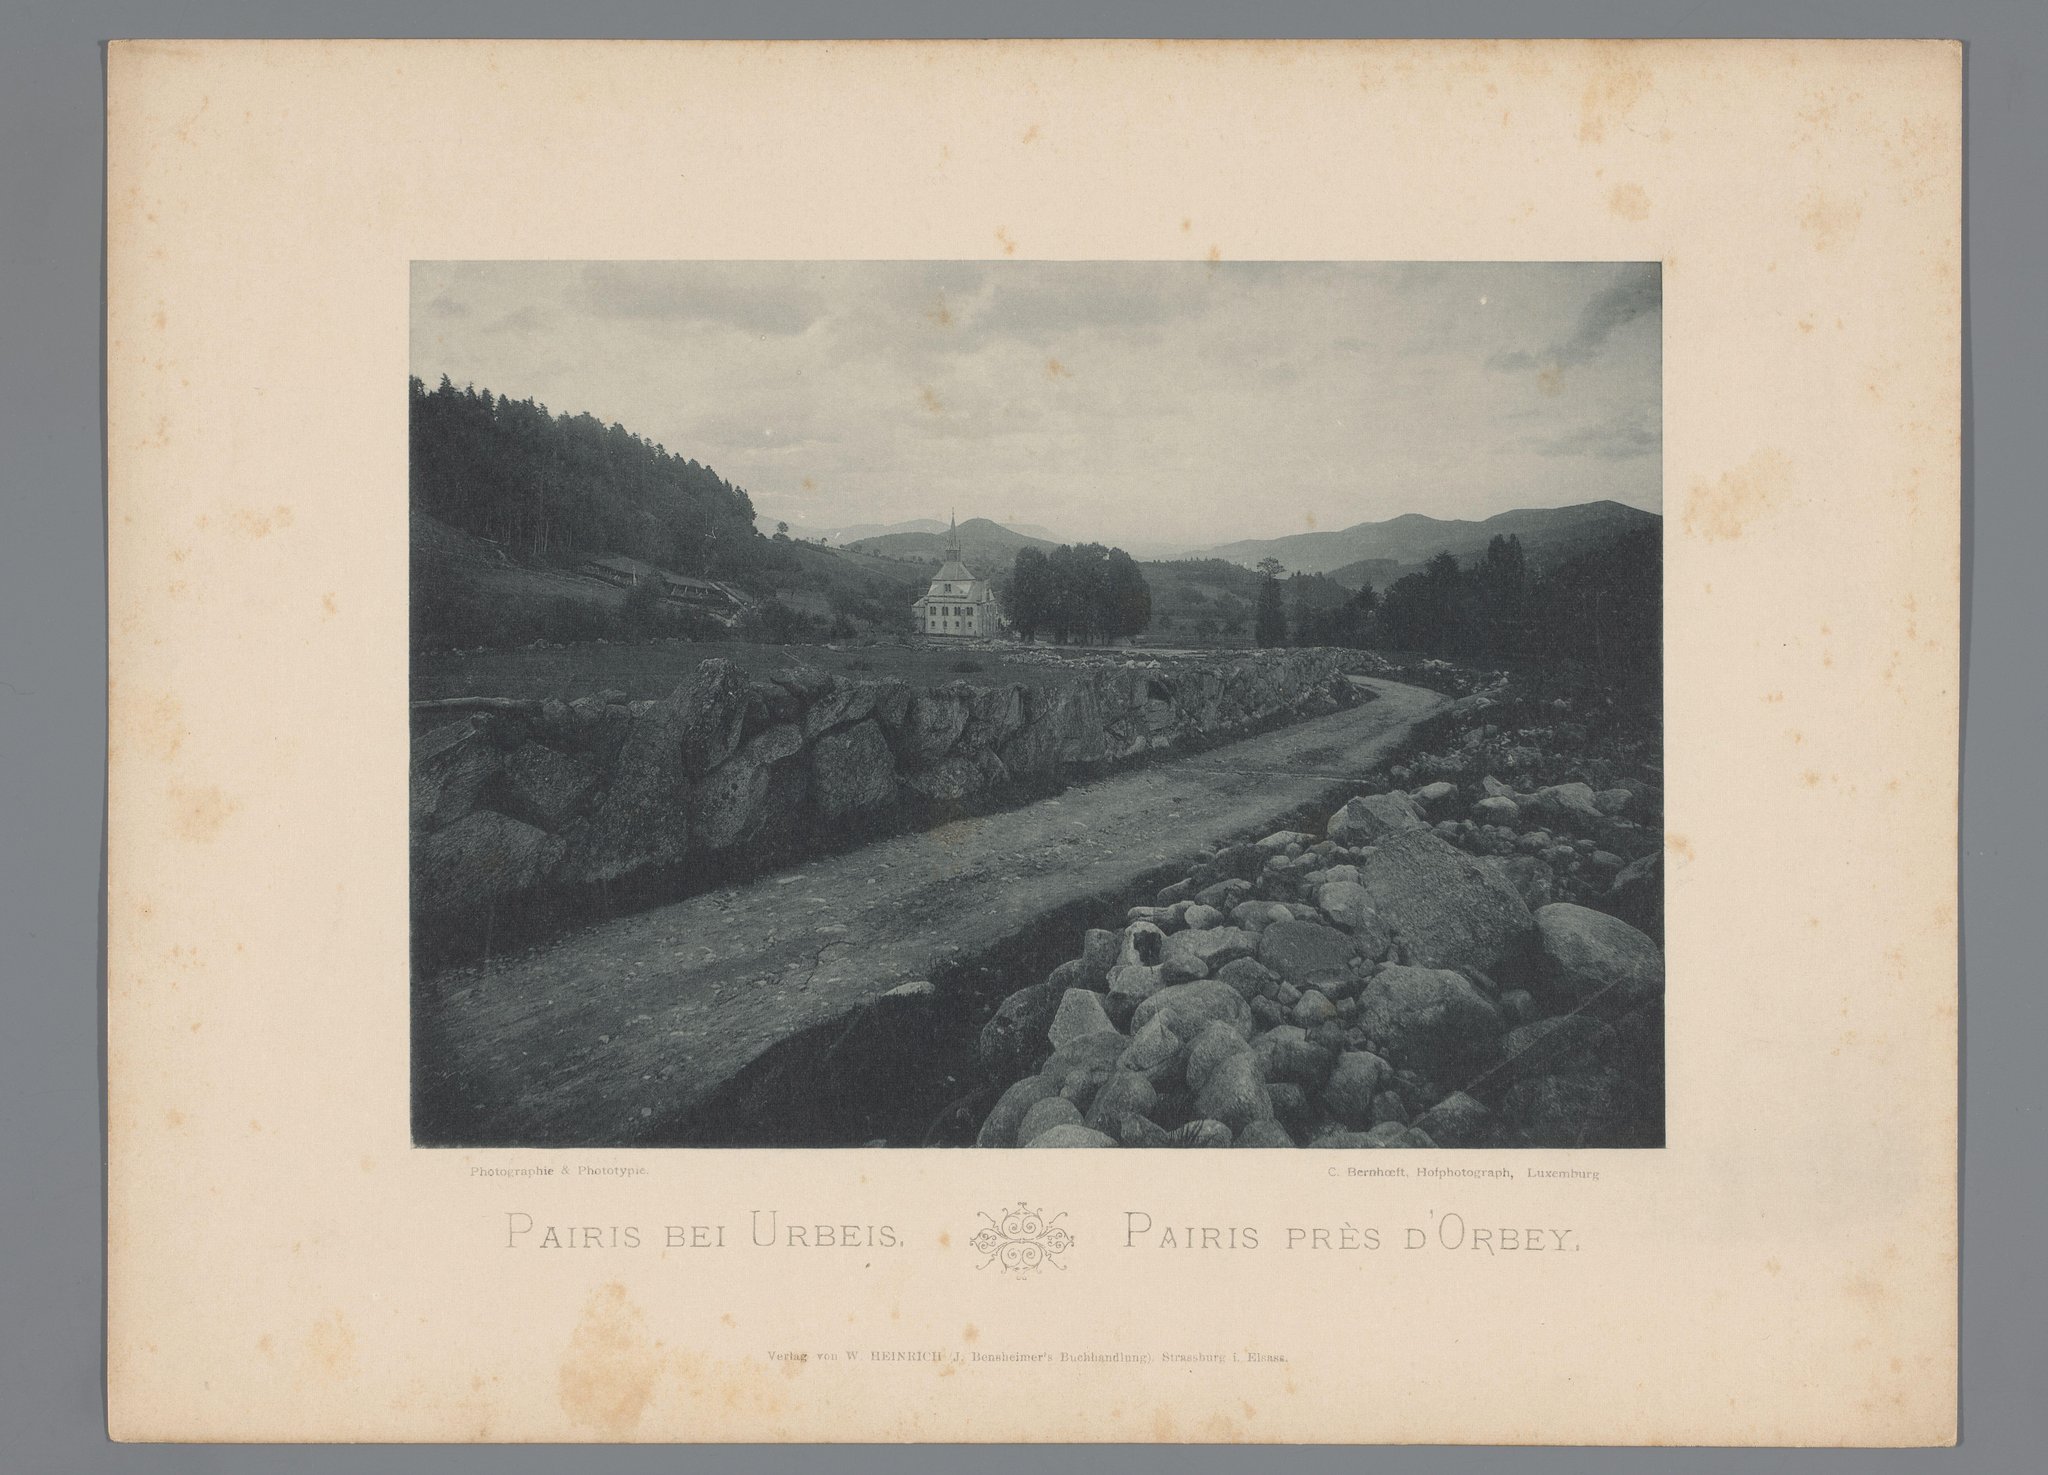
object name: photomechanical print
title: Pairis bei Urbeis, Pairis près d'Orbey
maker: charles bernhoeft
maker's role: publisher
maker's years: 1859-1933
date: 1889-1894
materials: paper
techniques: photograph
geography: luxembourg city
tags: abbey, monastery, convent ~ roman catholic church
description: Deze prent maakt deel uit van een omslag met 100 prenten.